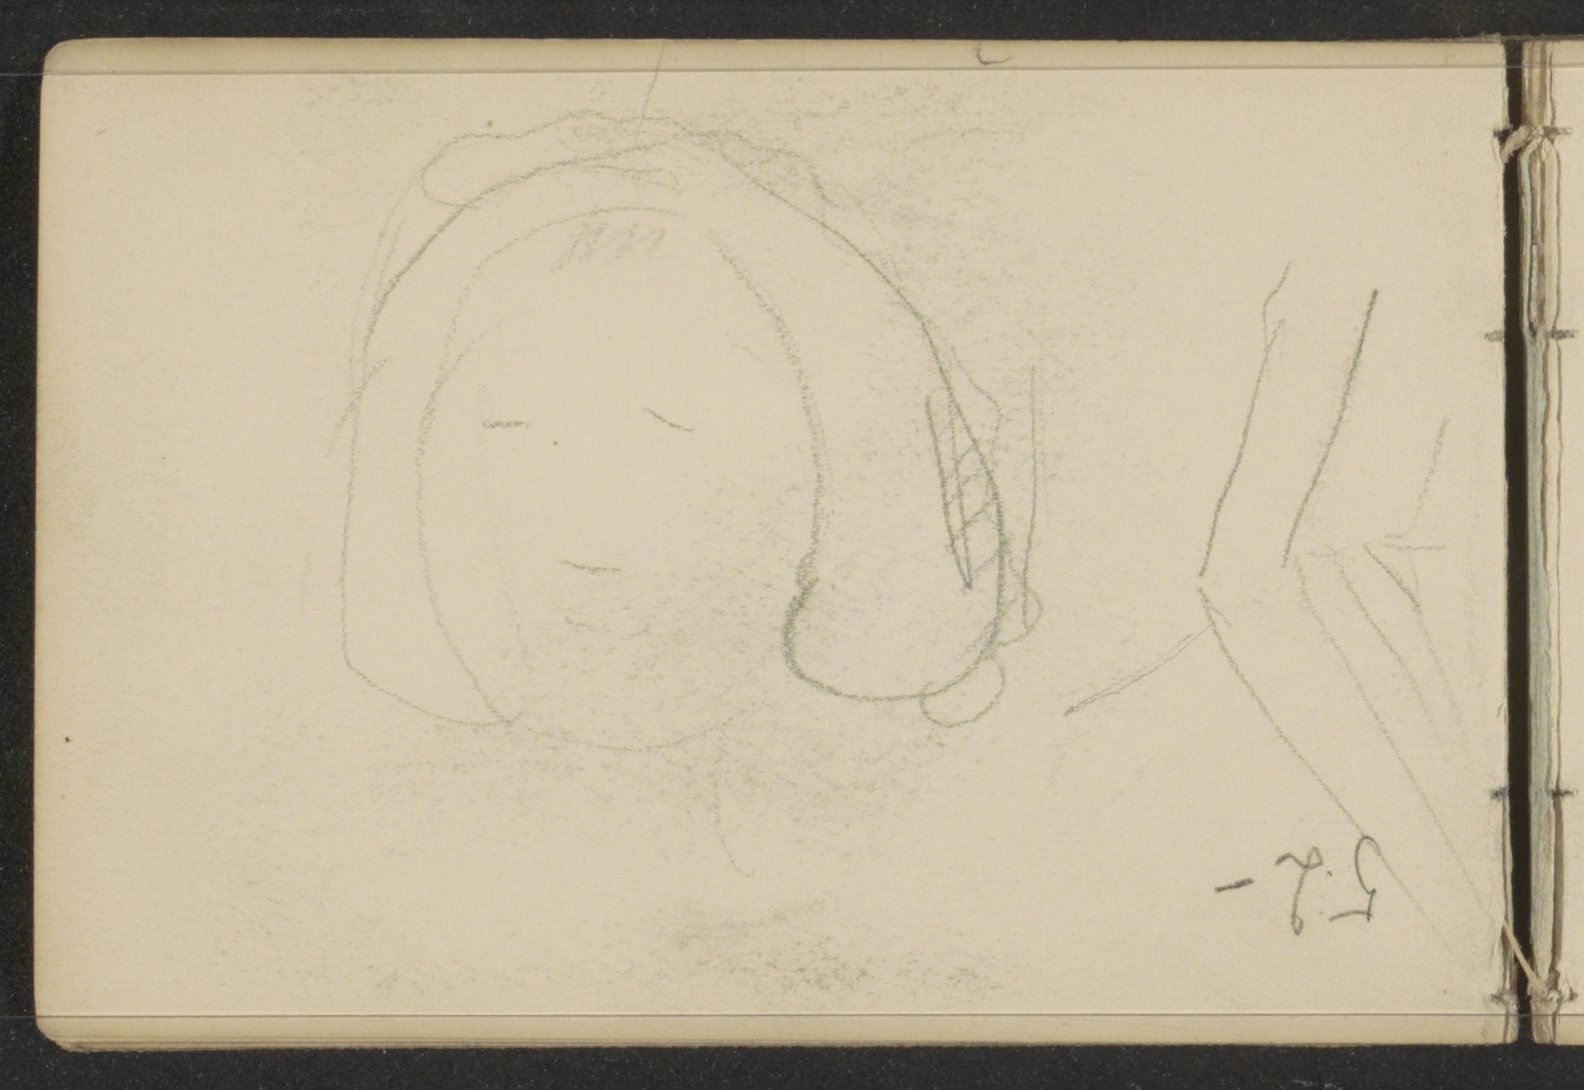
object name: sketchbook leaf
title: Meisjeskop en een dak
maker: Anonymous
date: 1880-1900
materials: paper, pencil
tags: roof (of house or building), head (human) - aa - female human figure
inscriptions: number: ‘52-’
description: Blad 3 verso uit een schetsboek met 29 bladen.